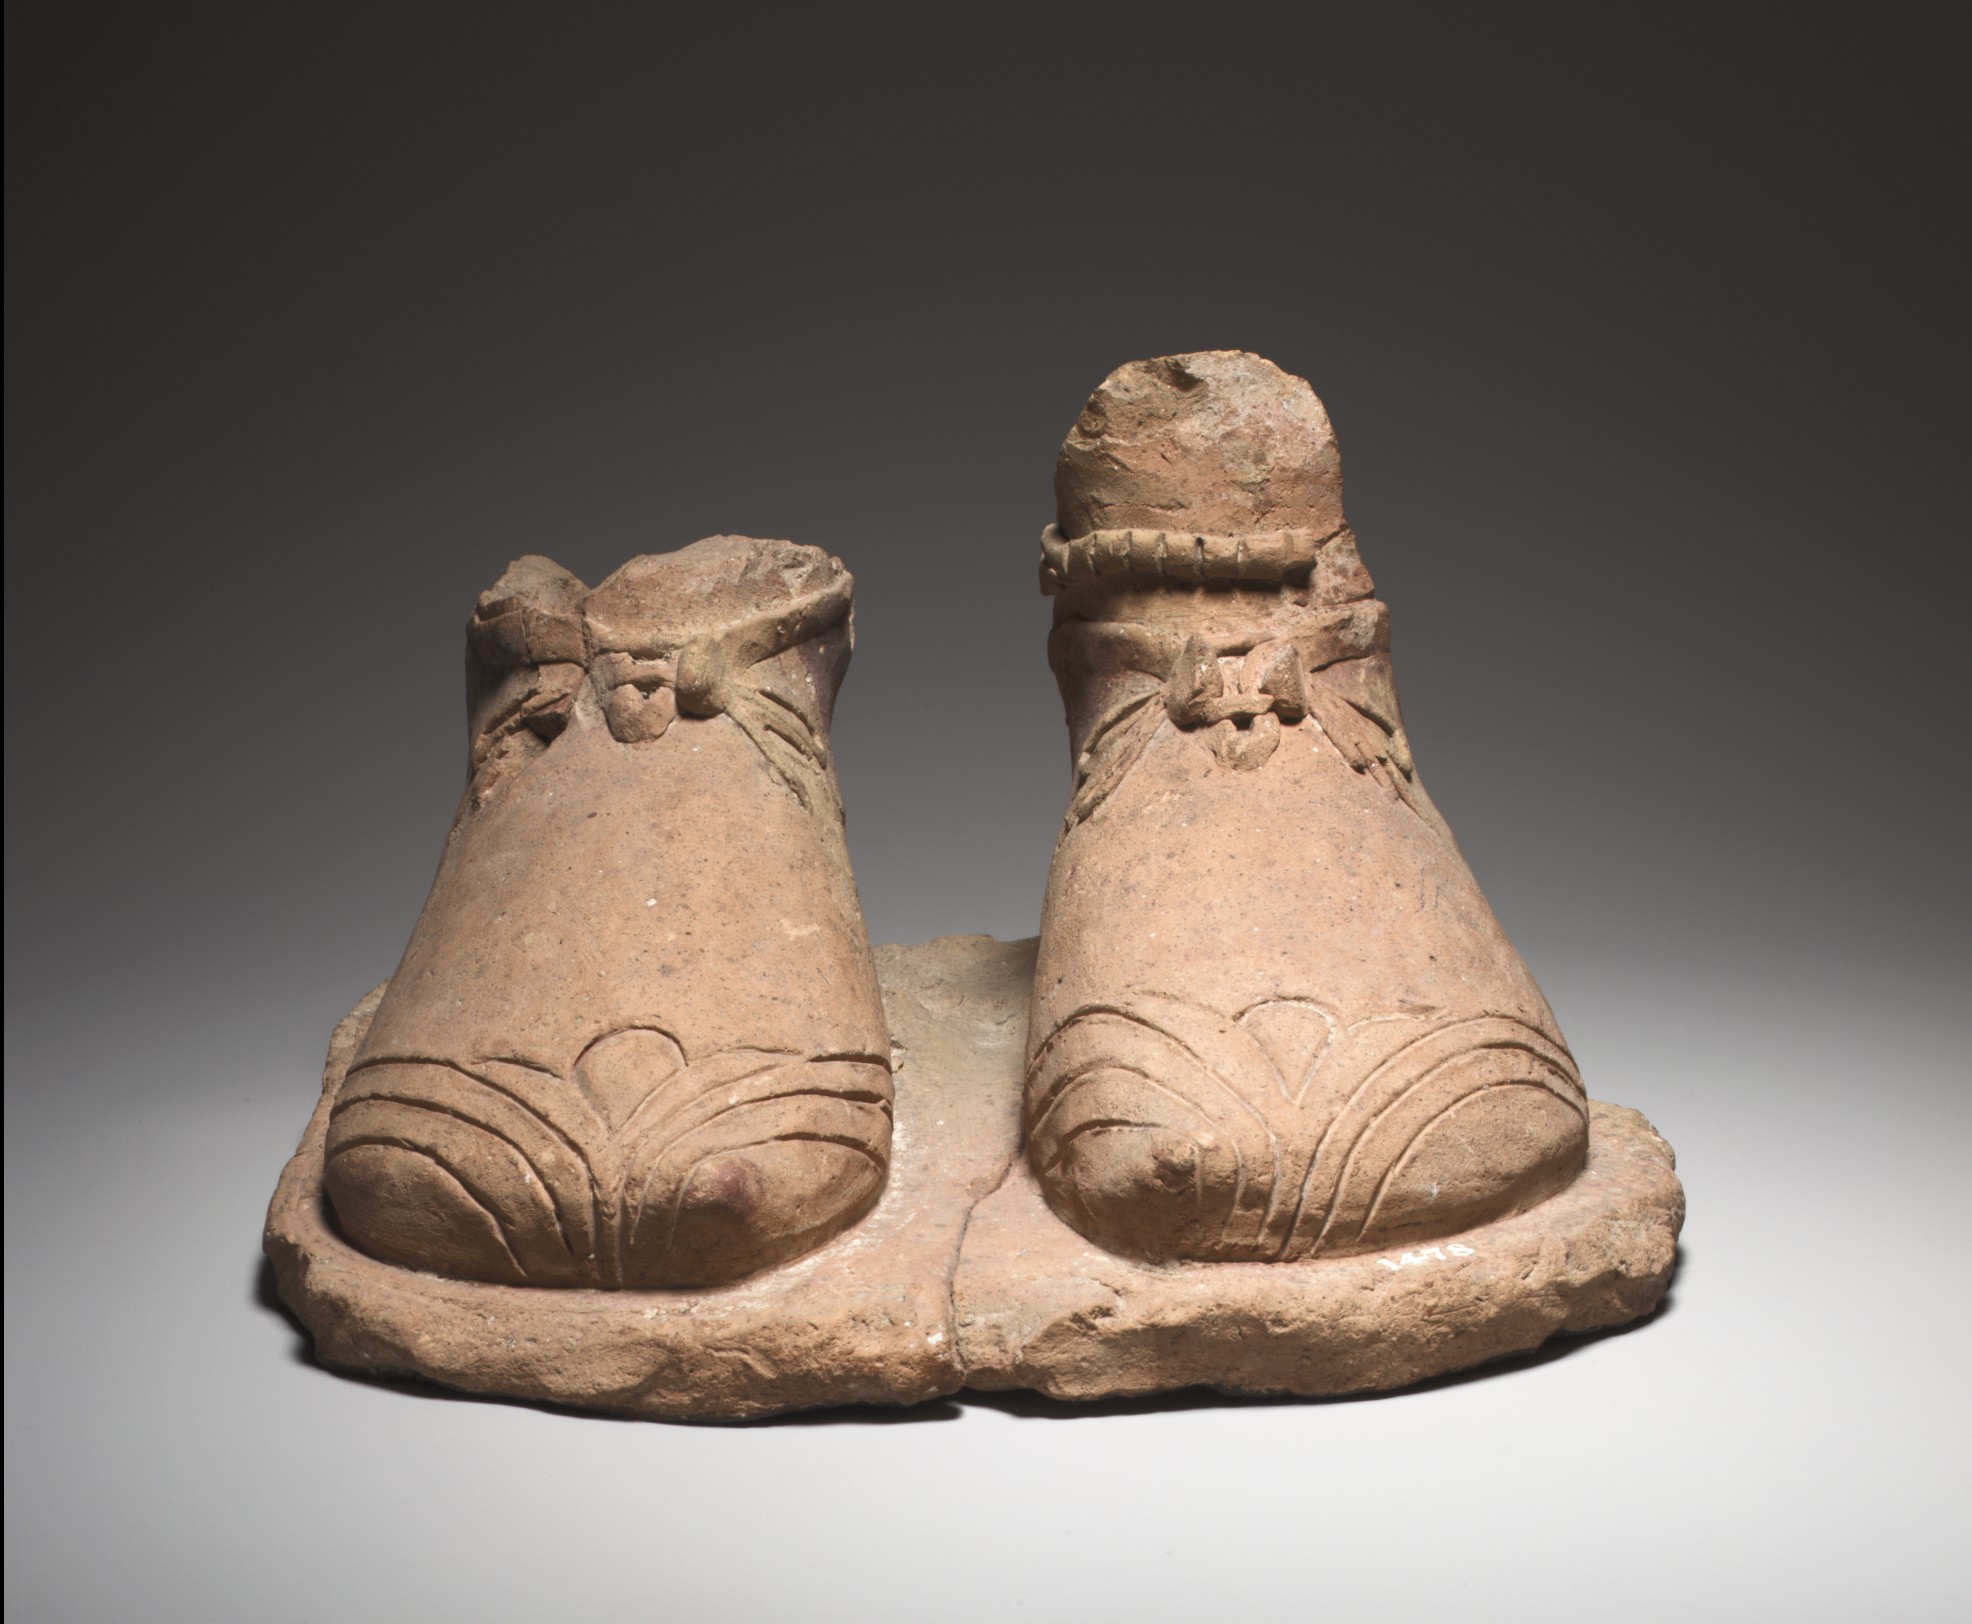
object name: foot on plinth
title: Feet on a plinth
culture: cypriot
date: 600-480 BCE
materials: terracotta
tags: feet